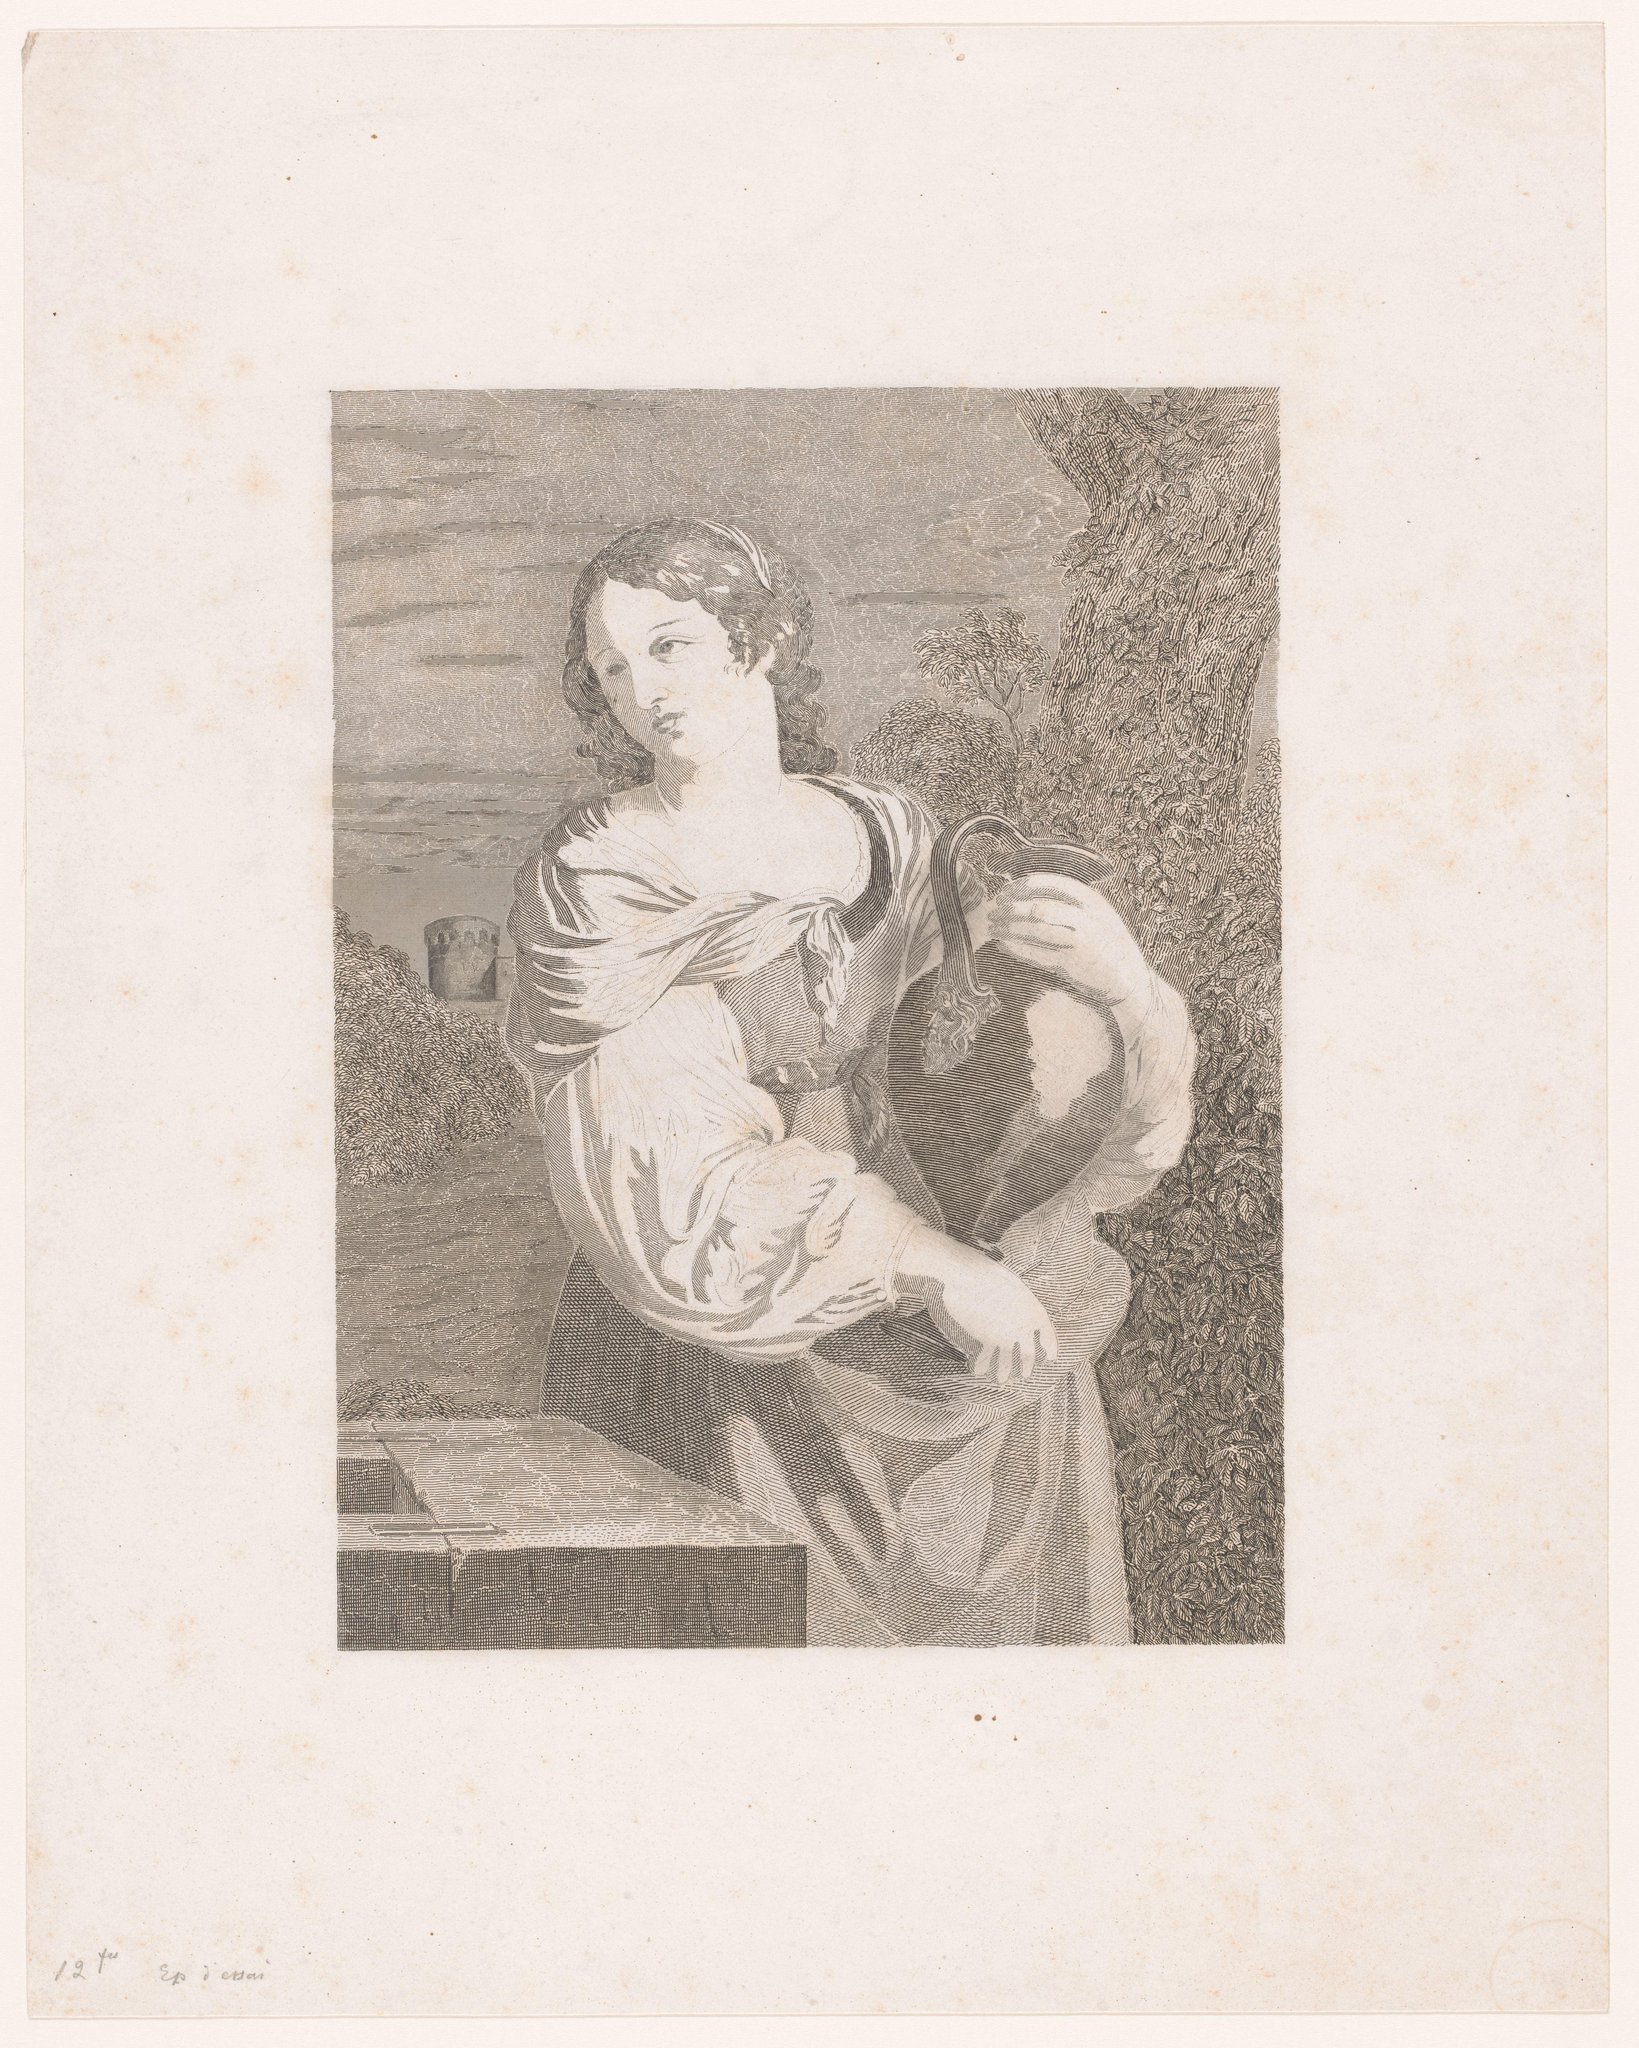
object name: print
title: Samaritaanse vrouw bij de waterput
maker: jean-baptiste meunier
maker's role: print maker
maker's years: 1821-1900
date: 1831-1900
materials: paper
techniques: etching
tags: the woman of samaria (john 4:4-42), container of ceramics: jar, jug, pot, vase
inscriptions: collector's mark: Lugt 2228